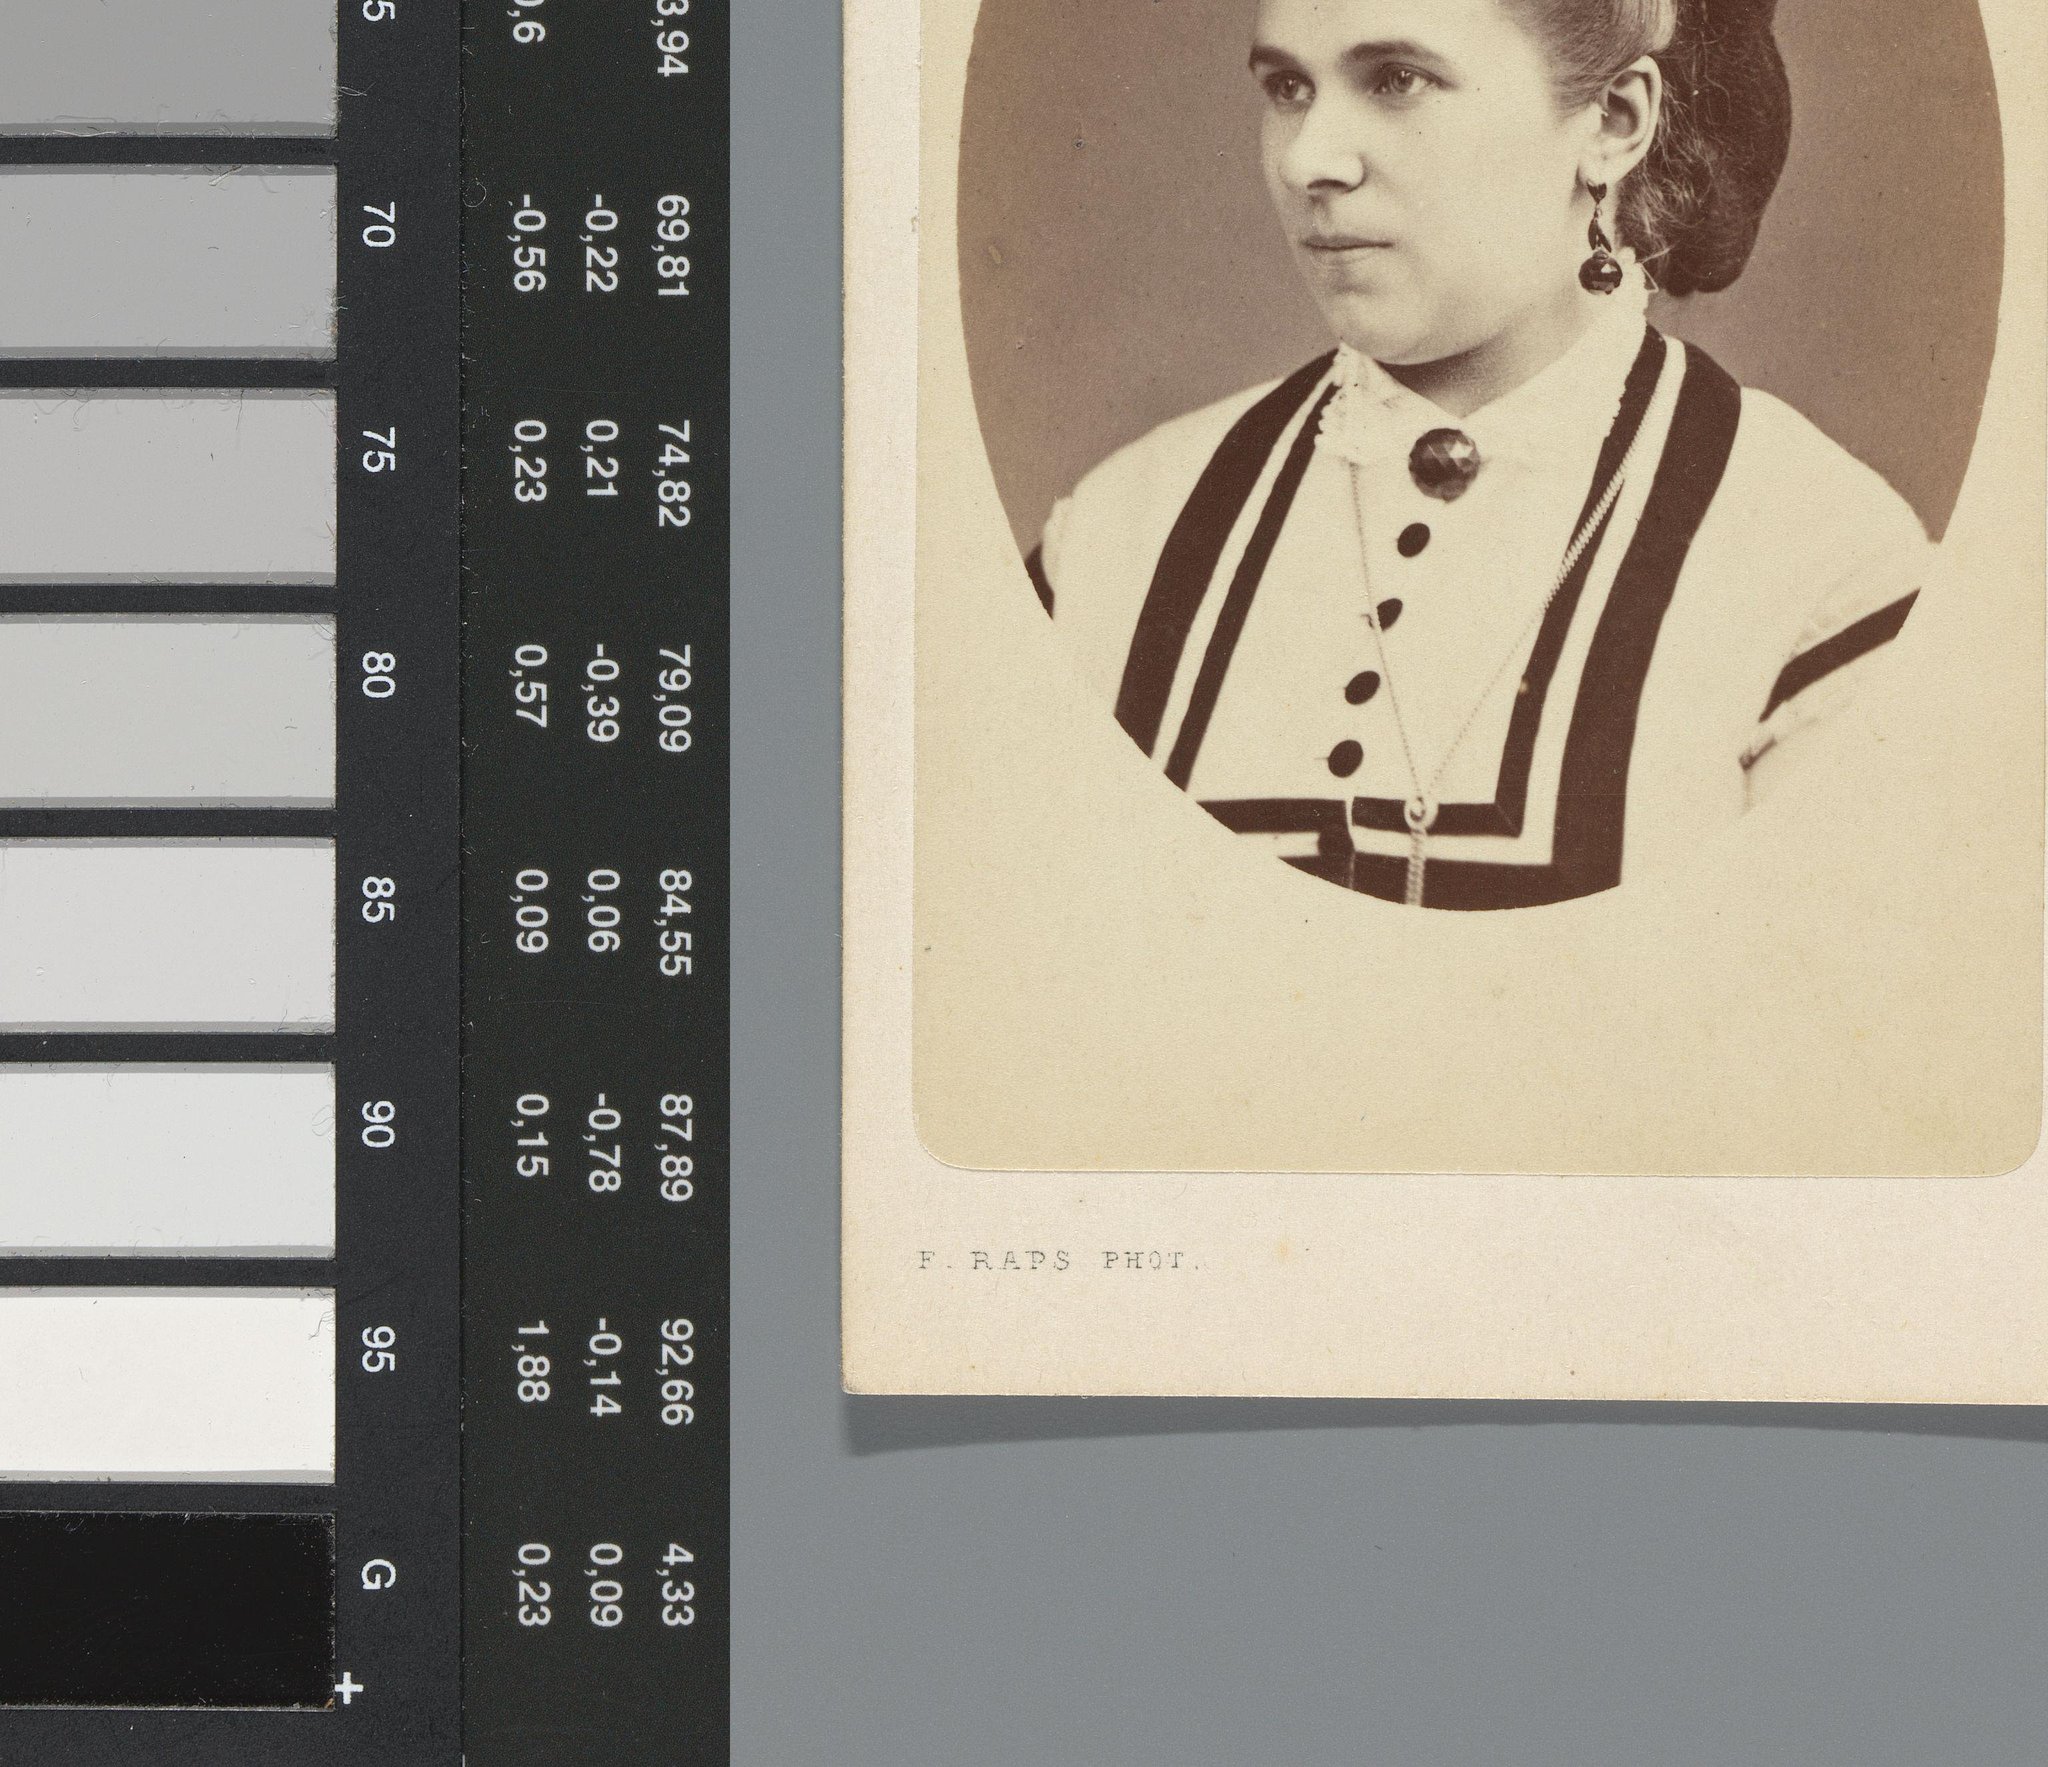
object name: photograph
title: Portret van Joanna Emilia Agnes van den Berg (Jeanette)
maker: friedrich raps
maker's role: fotograaf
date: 1855-1910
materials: cardboard, photographic support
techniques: albumen print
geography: cologne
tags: the hague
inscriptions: name: ‘FIRMA S. SALLINGER & Cie / F> RAPS / 16 Comödienstrasse / COELN’, inscription: ‘Tante Jeannette Trip / van den Berg’, name: ‘F. RAPS PHOT.’